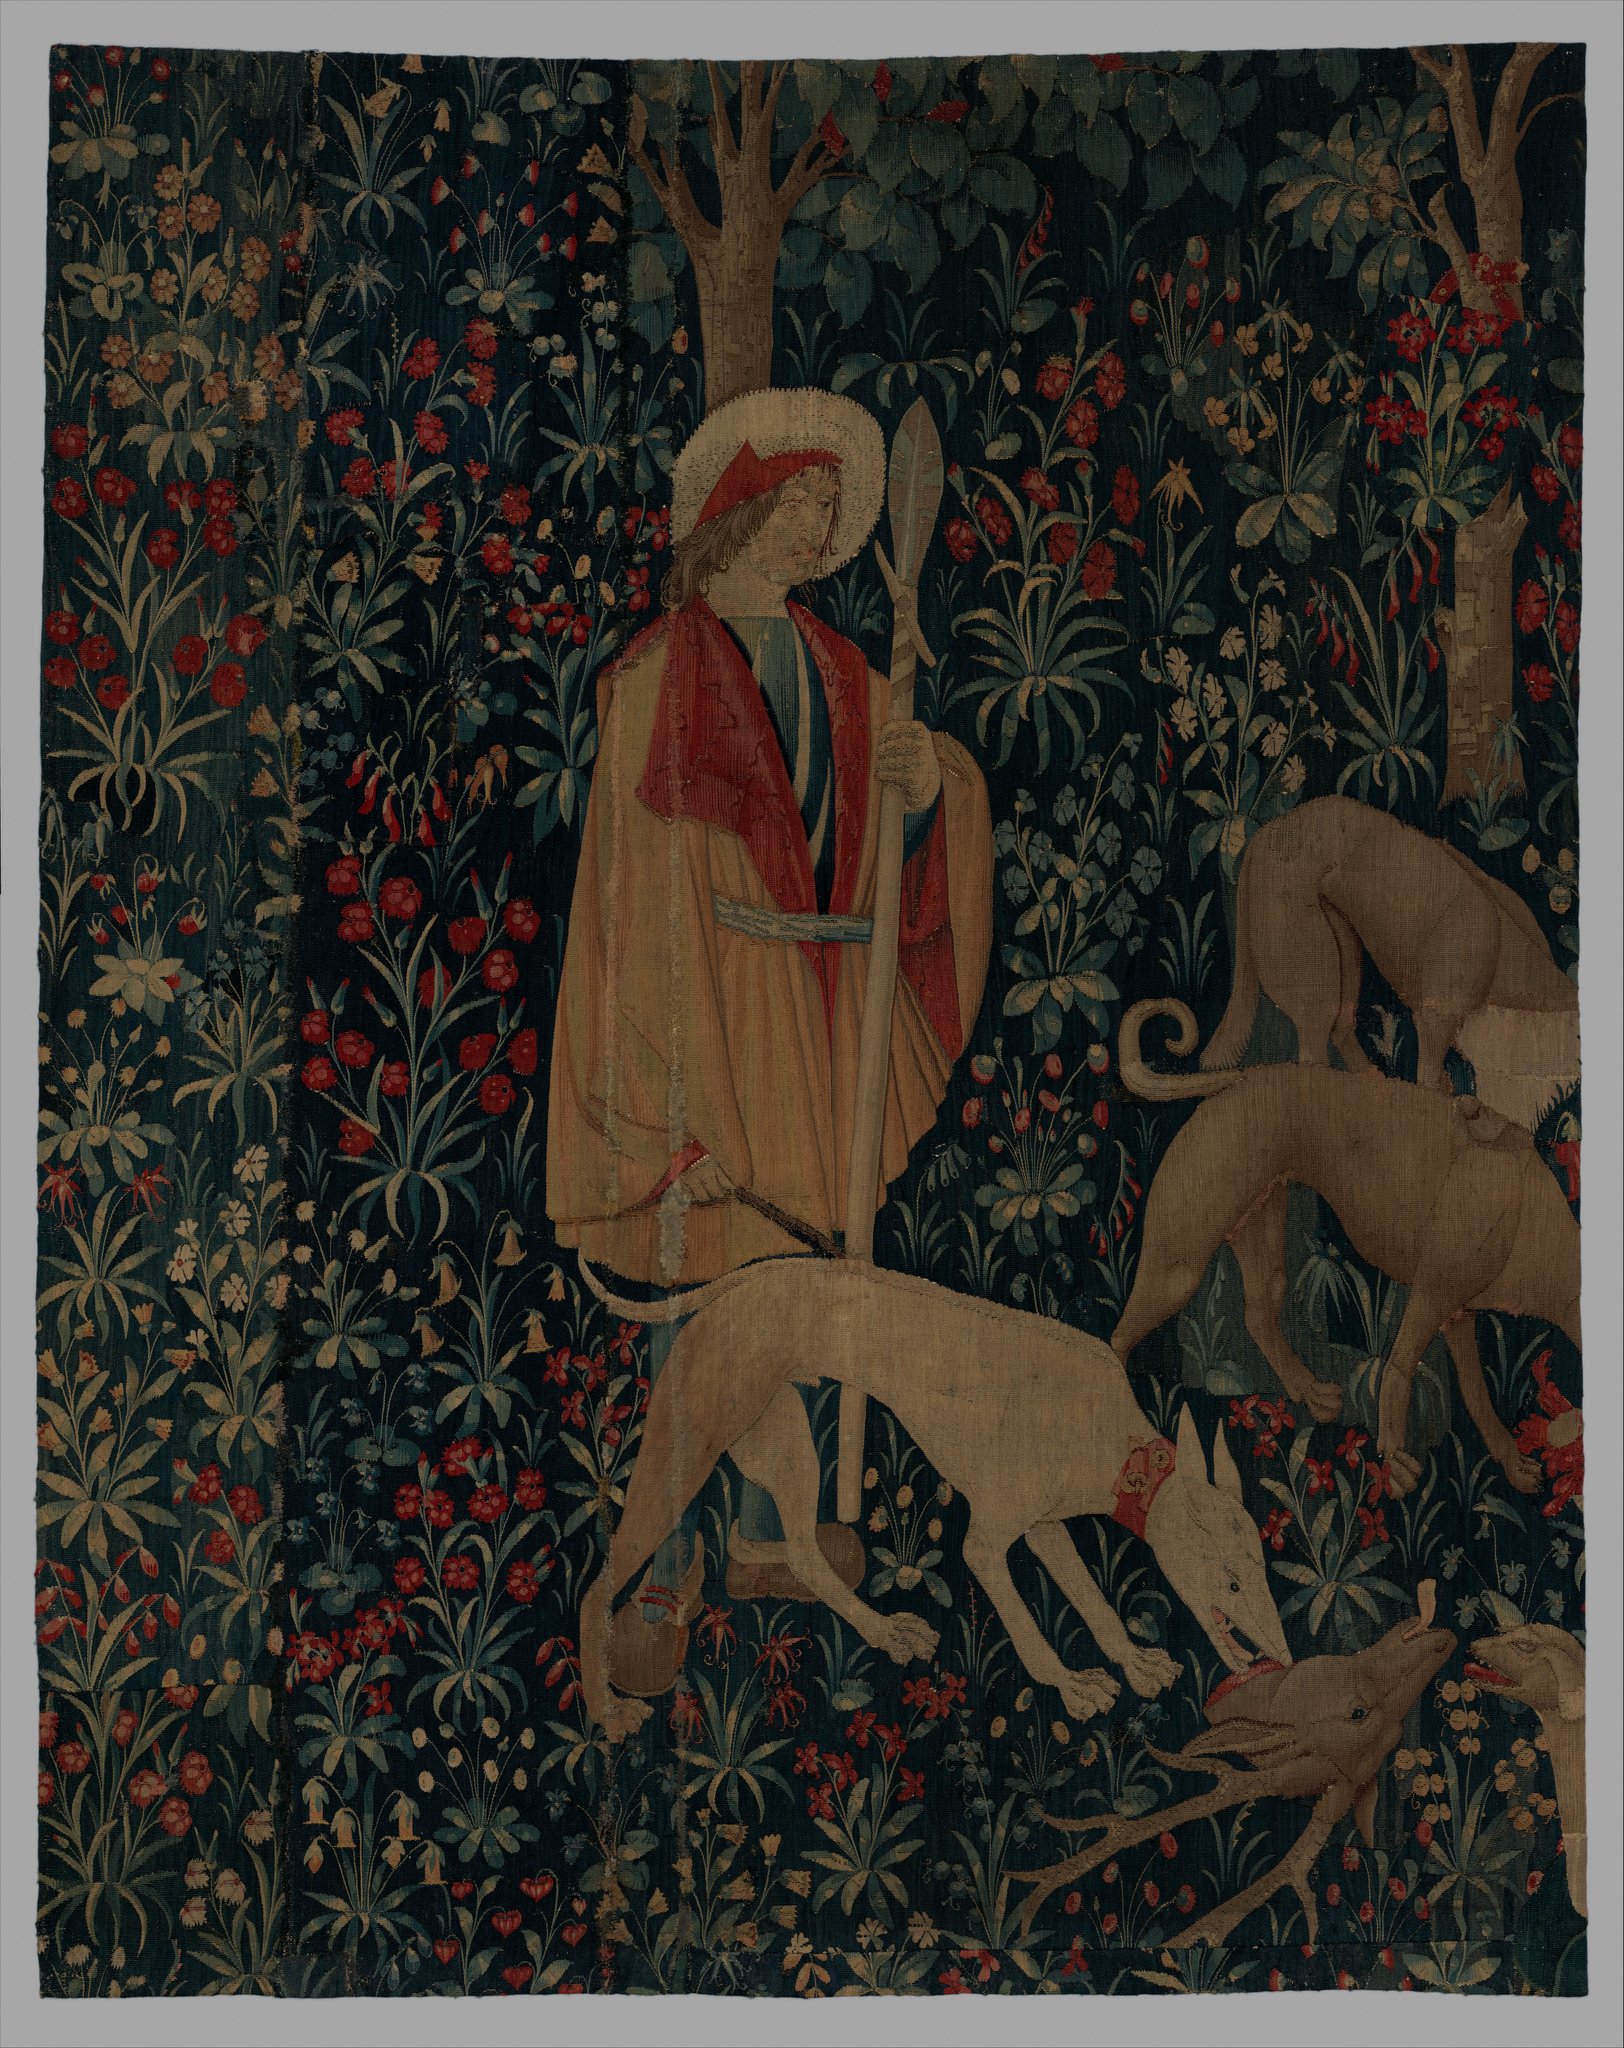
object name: tapestry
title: Preparing to Undo the Stag in the Field (From Incidents in a Stag Hunt)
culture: south netherlandish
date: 1495-1515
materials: wool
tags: deer,dogs,flowers